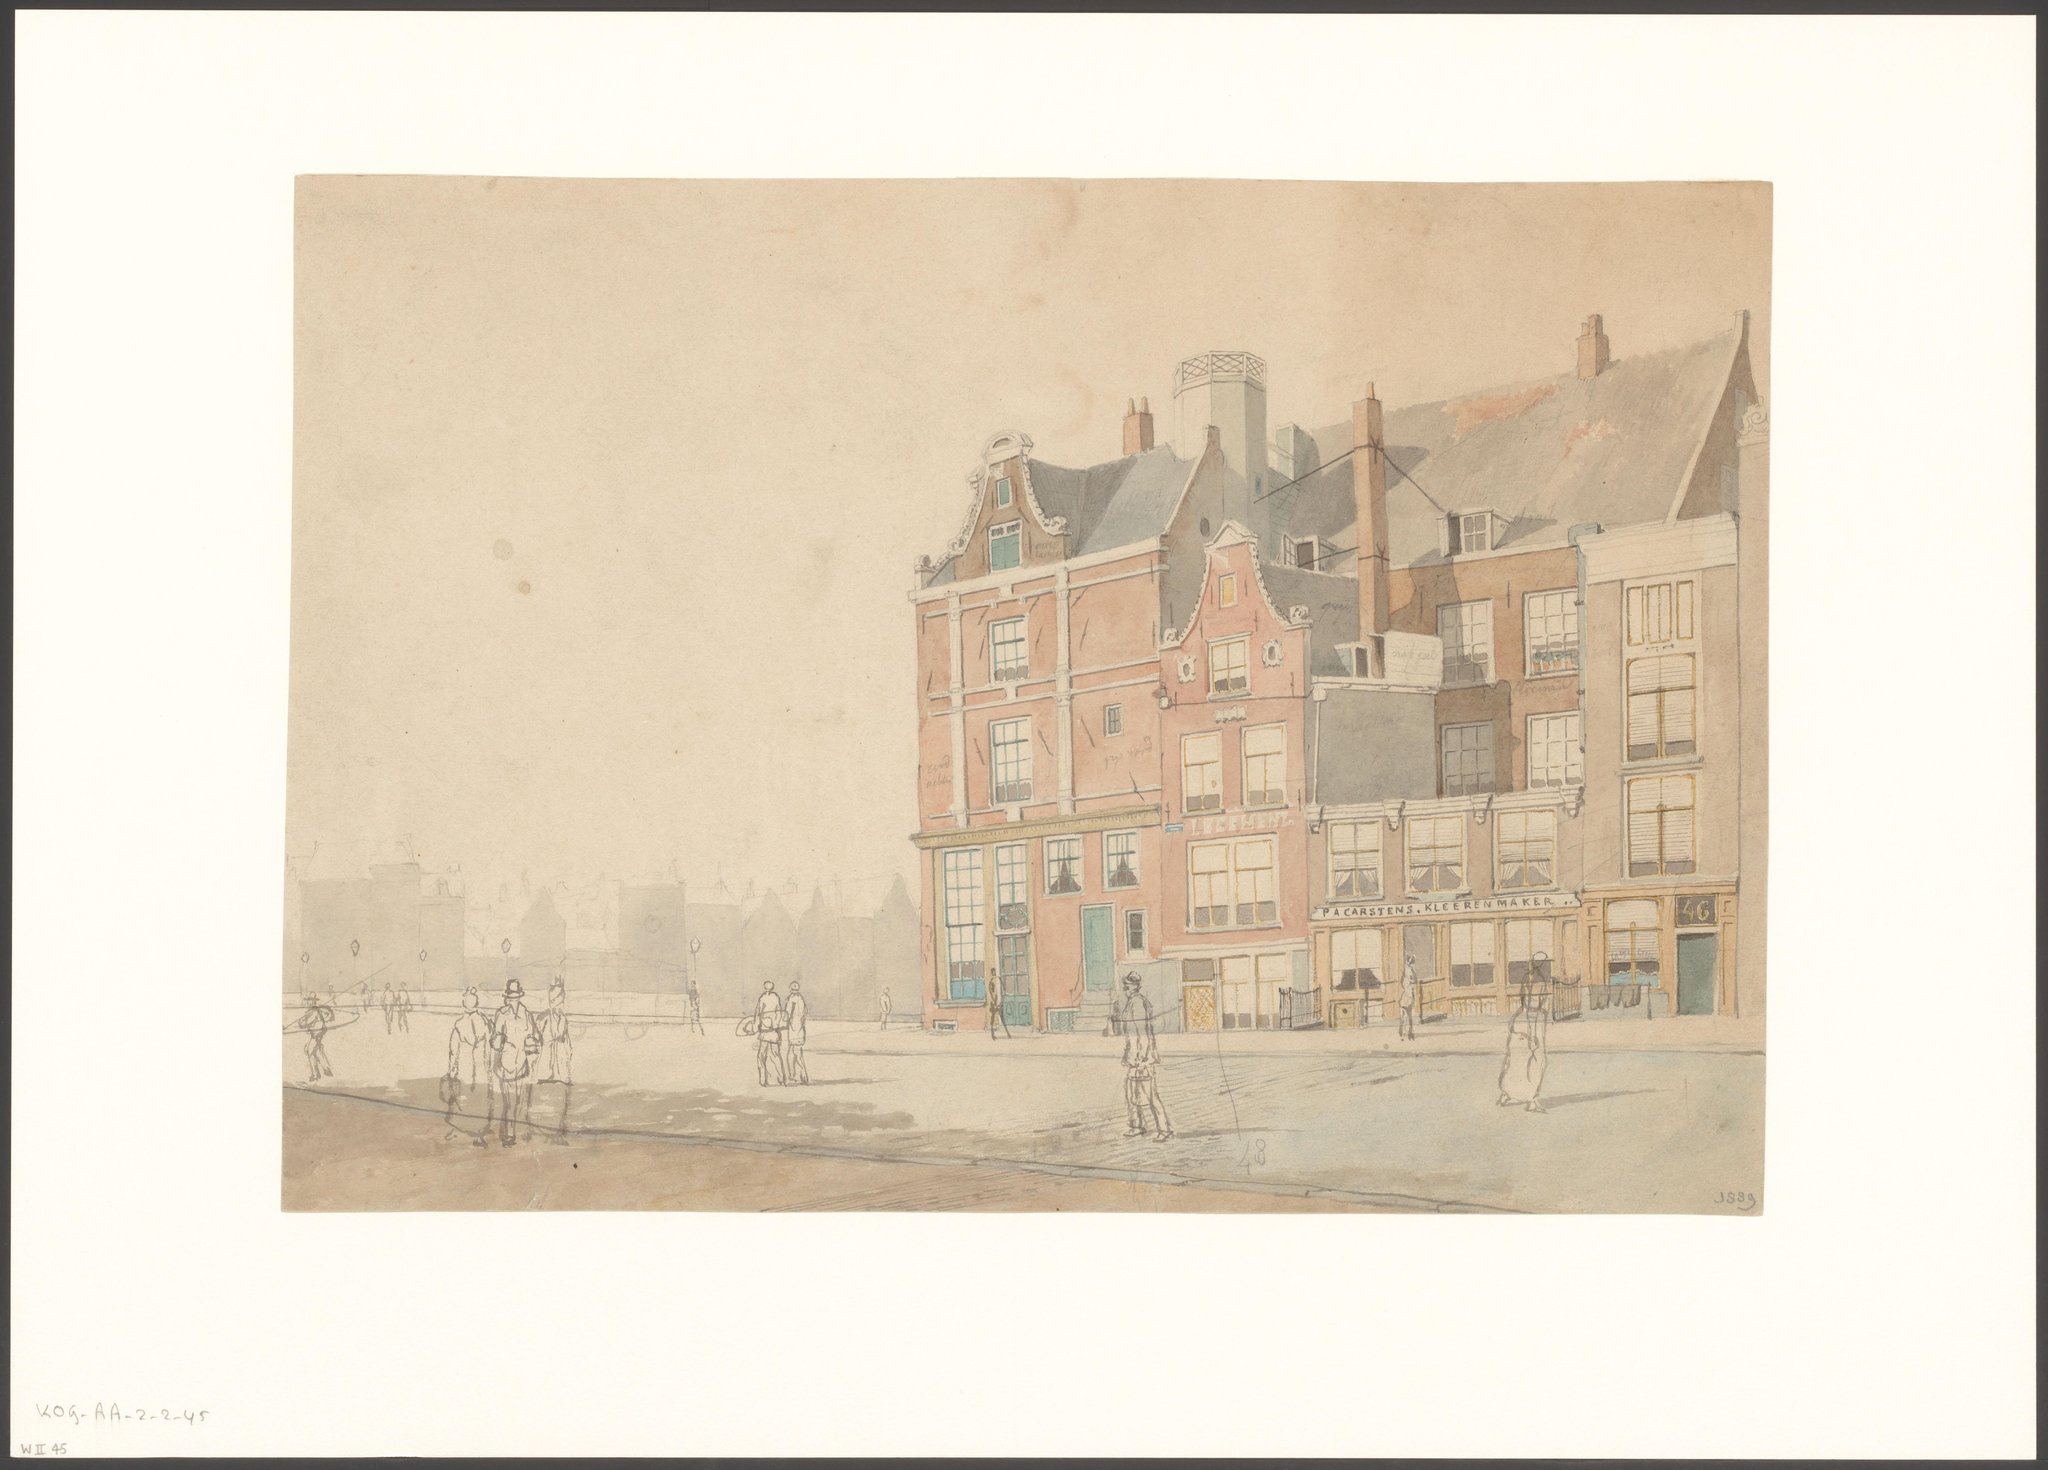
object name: drawing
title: Gezicht op de Texelsche Kade, hoek Damrak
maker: johan martinus anthon rieke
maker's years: 1851-1899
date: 1889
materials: paper, pencil, watercolor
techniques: brush, pen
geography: amsterdam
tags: city-view in general; 'veduta', façade (of house or building), street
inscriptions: date: ‘1889’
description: Tekening binnen de Atlas Van Eck ingedeeld op wijknummer 2.